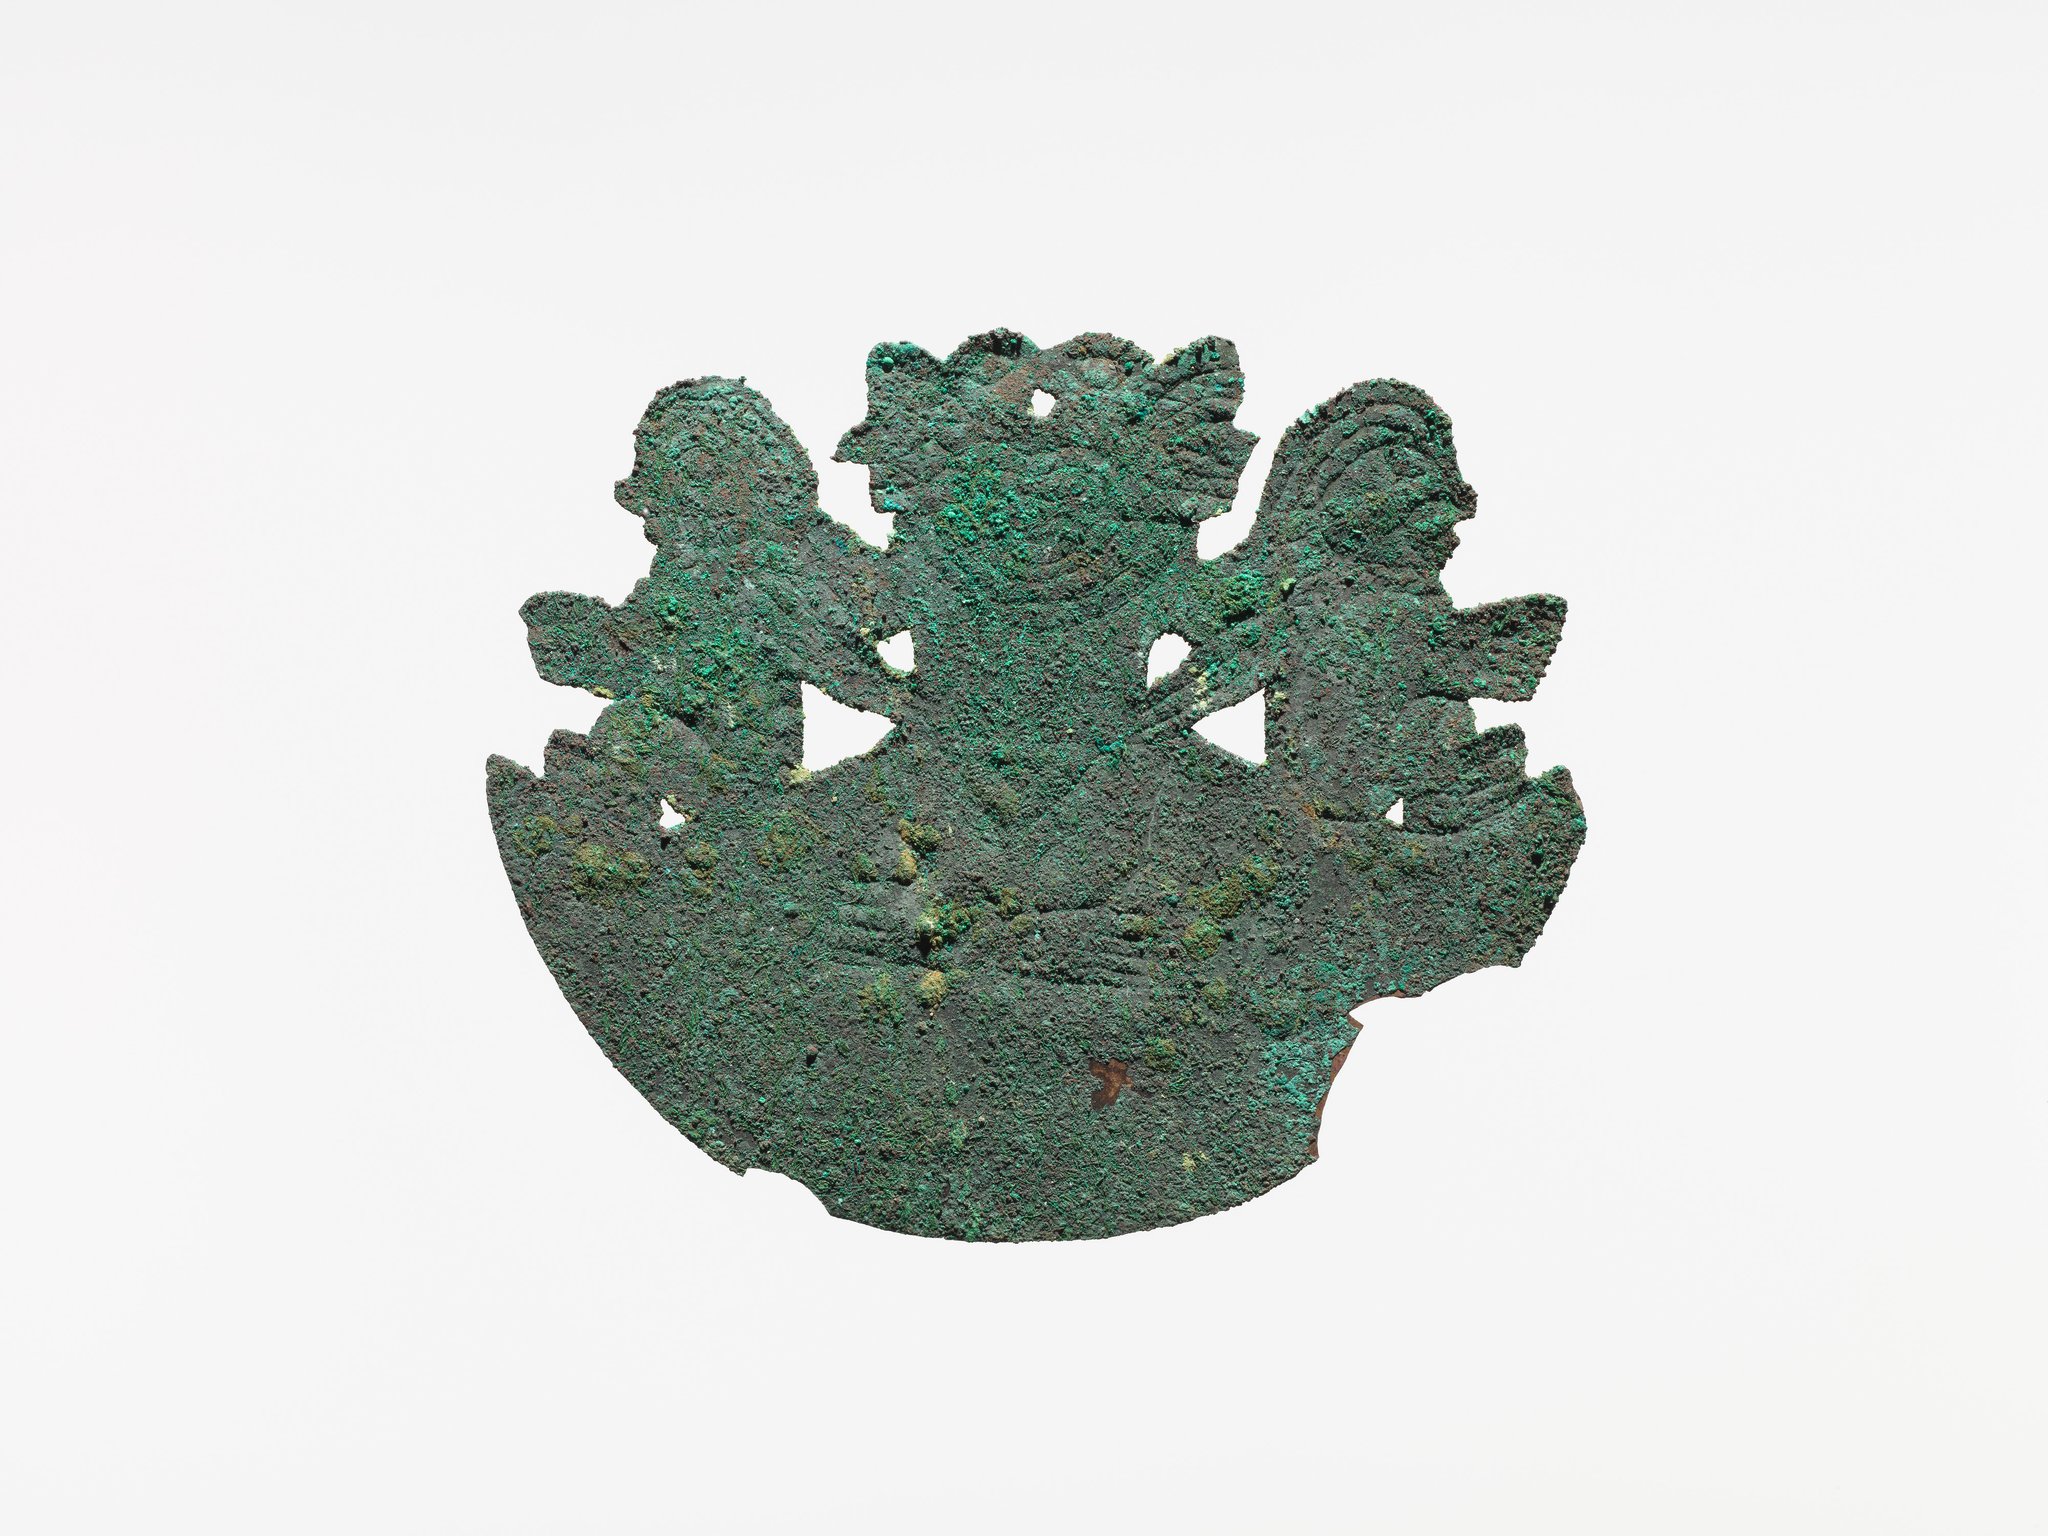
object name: ornament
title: Crescent Ornament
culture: moche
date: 501-700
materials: metal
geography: peru